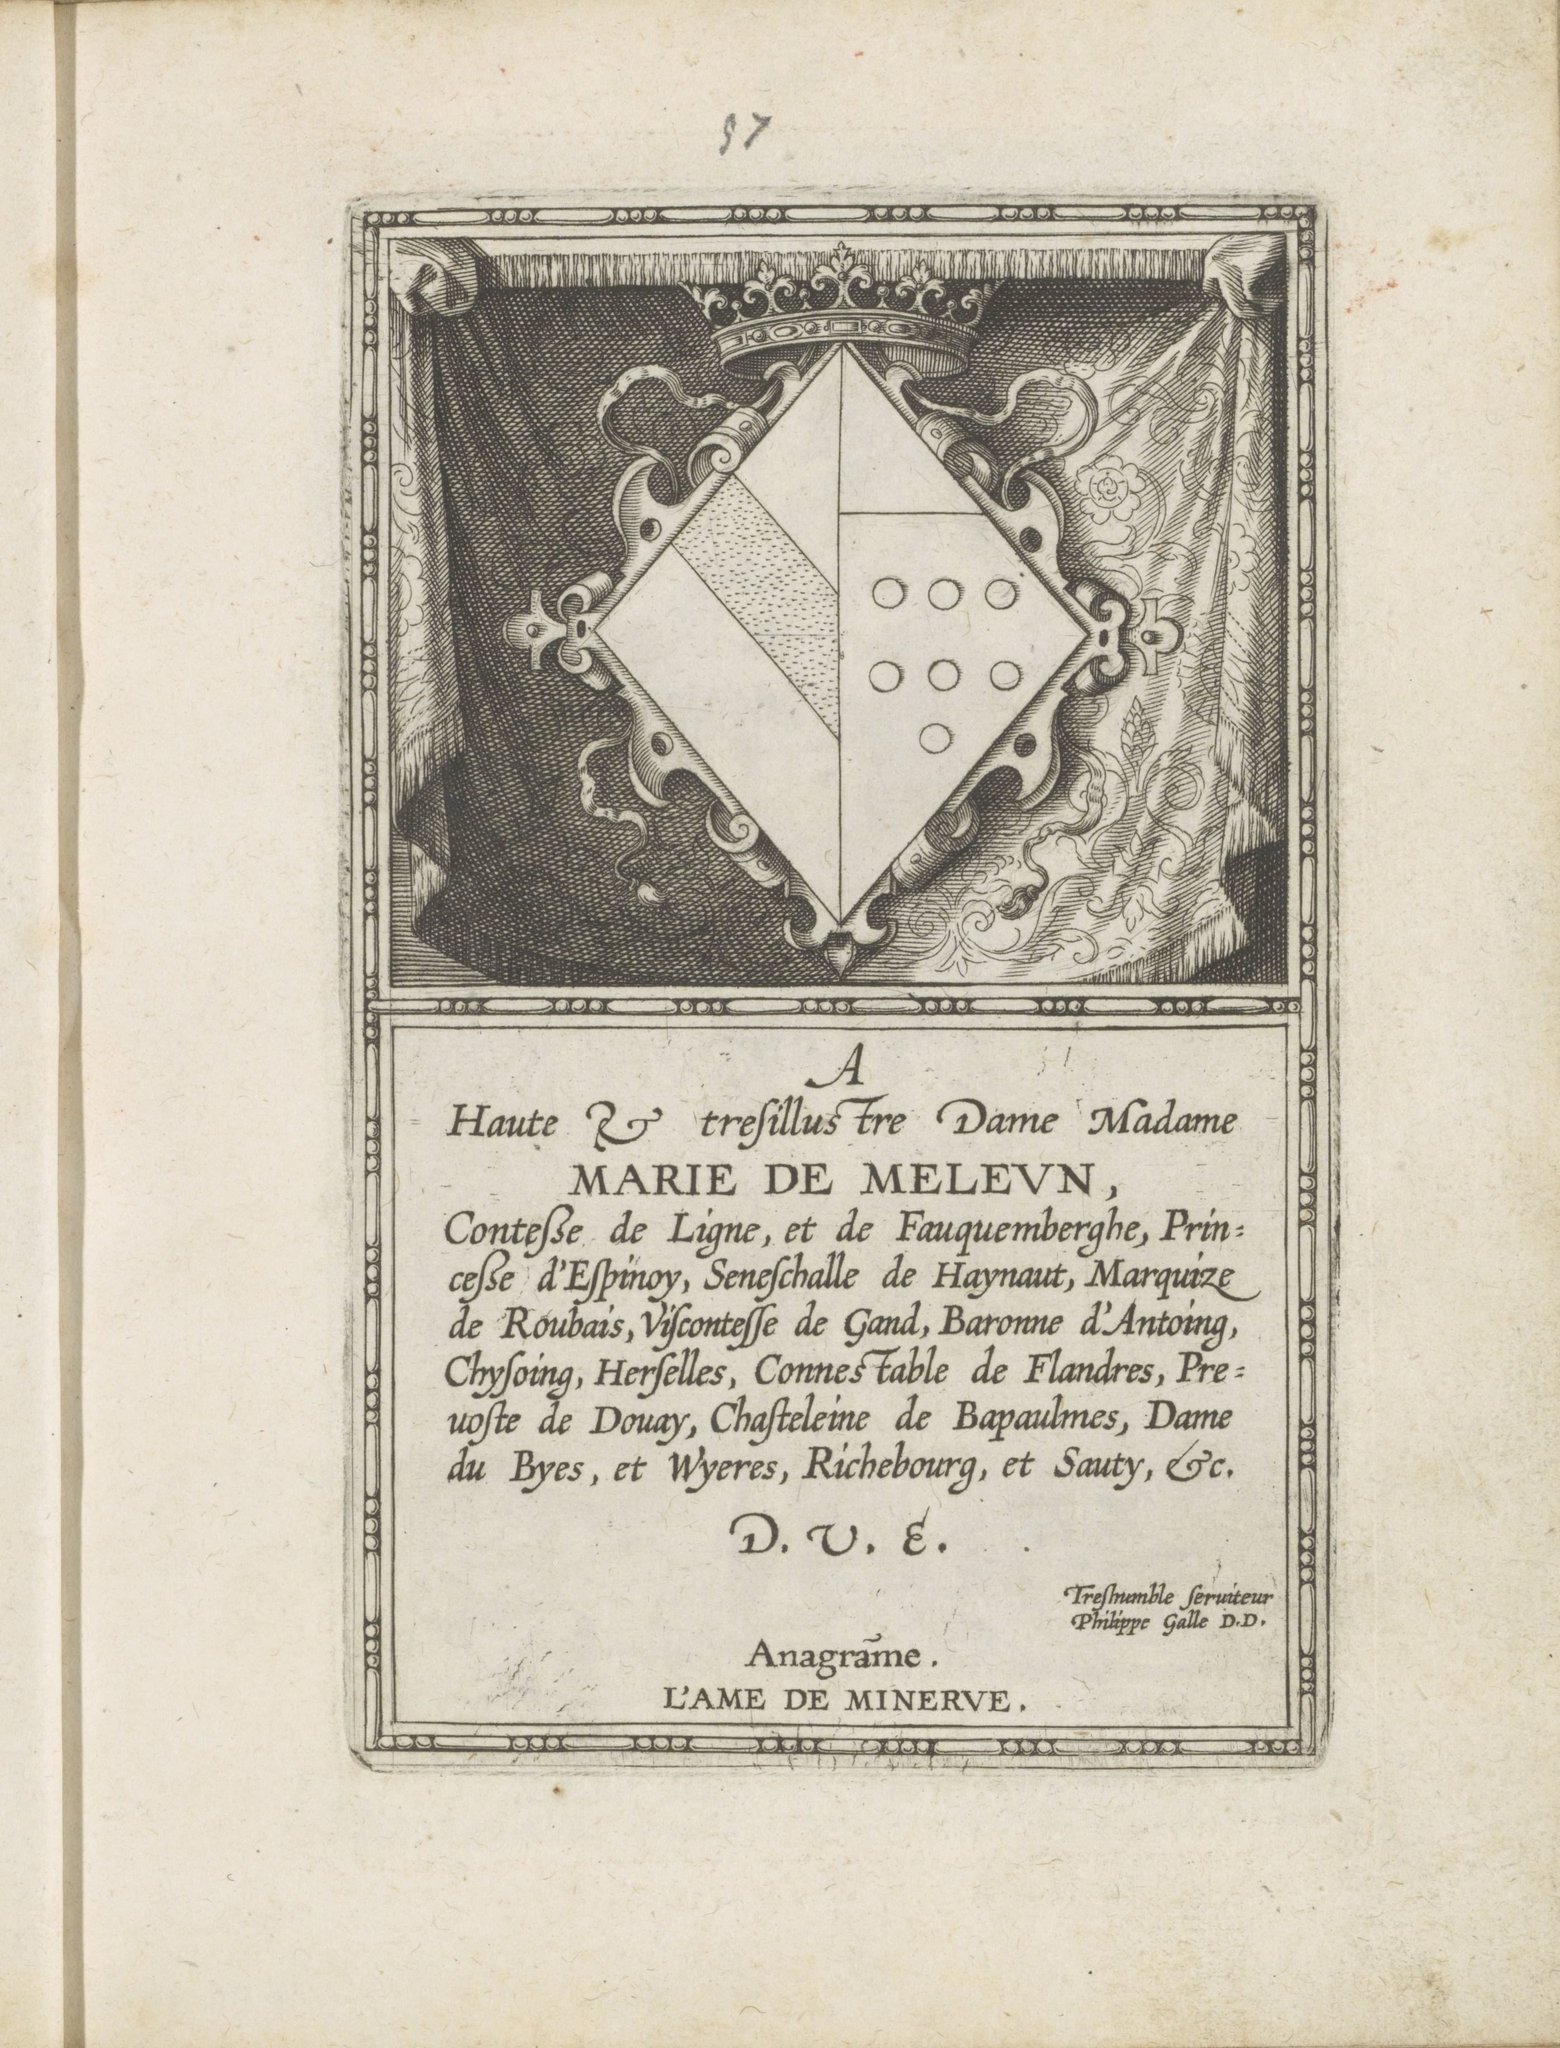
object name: album leaf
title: Prosopographia, sive virtutum, animi, corporis, bonorum externorum, vitiorum, et affectuum variorum delineatio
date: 1585-1590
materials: paper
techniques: engraving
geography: antwerp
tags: armorial bearing, heraldry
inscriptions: collector's mark: Lugt 2228, collector's mark: Lugt 2760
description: Voorstelling in twee delen. Bovenaan een gordijn met daarvoor het wapen van Marie de Meleun, gravin van Ligne. Daaronder een opdracht van de prentmaker aan dezelfde gravin. Onderaan een anagram: L'Ame de Minerve. De prent maakt deel uit van een album.